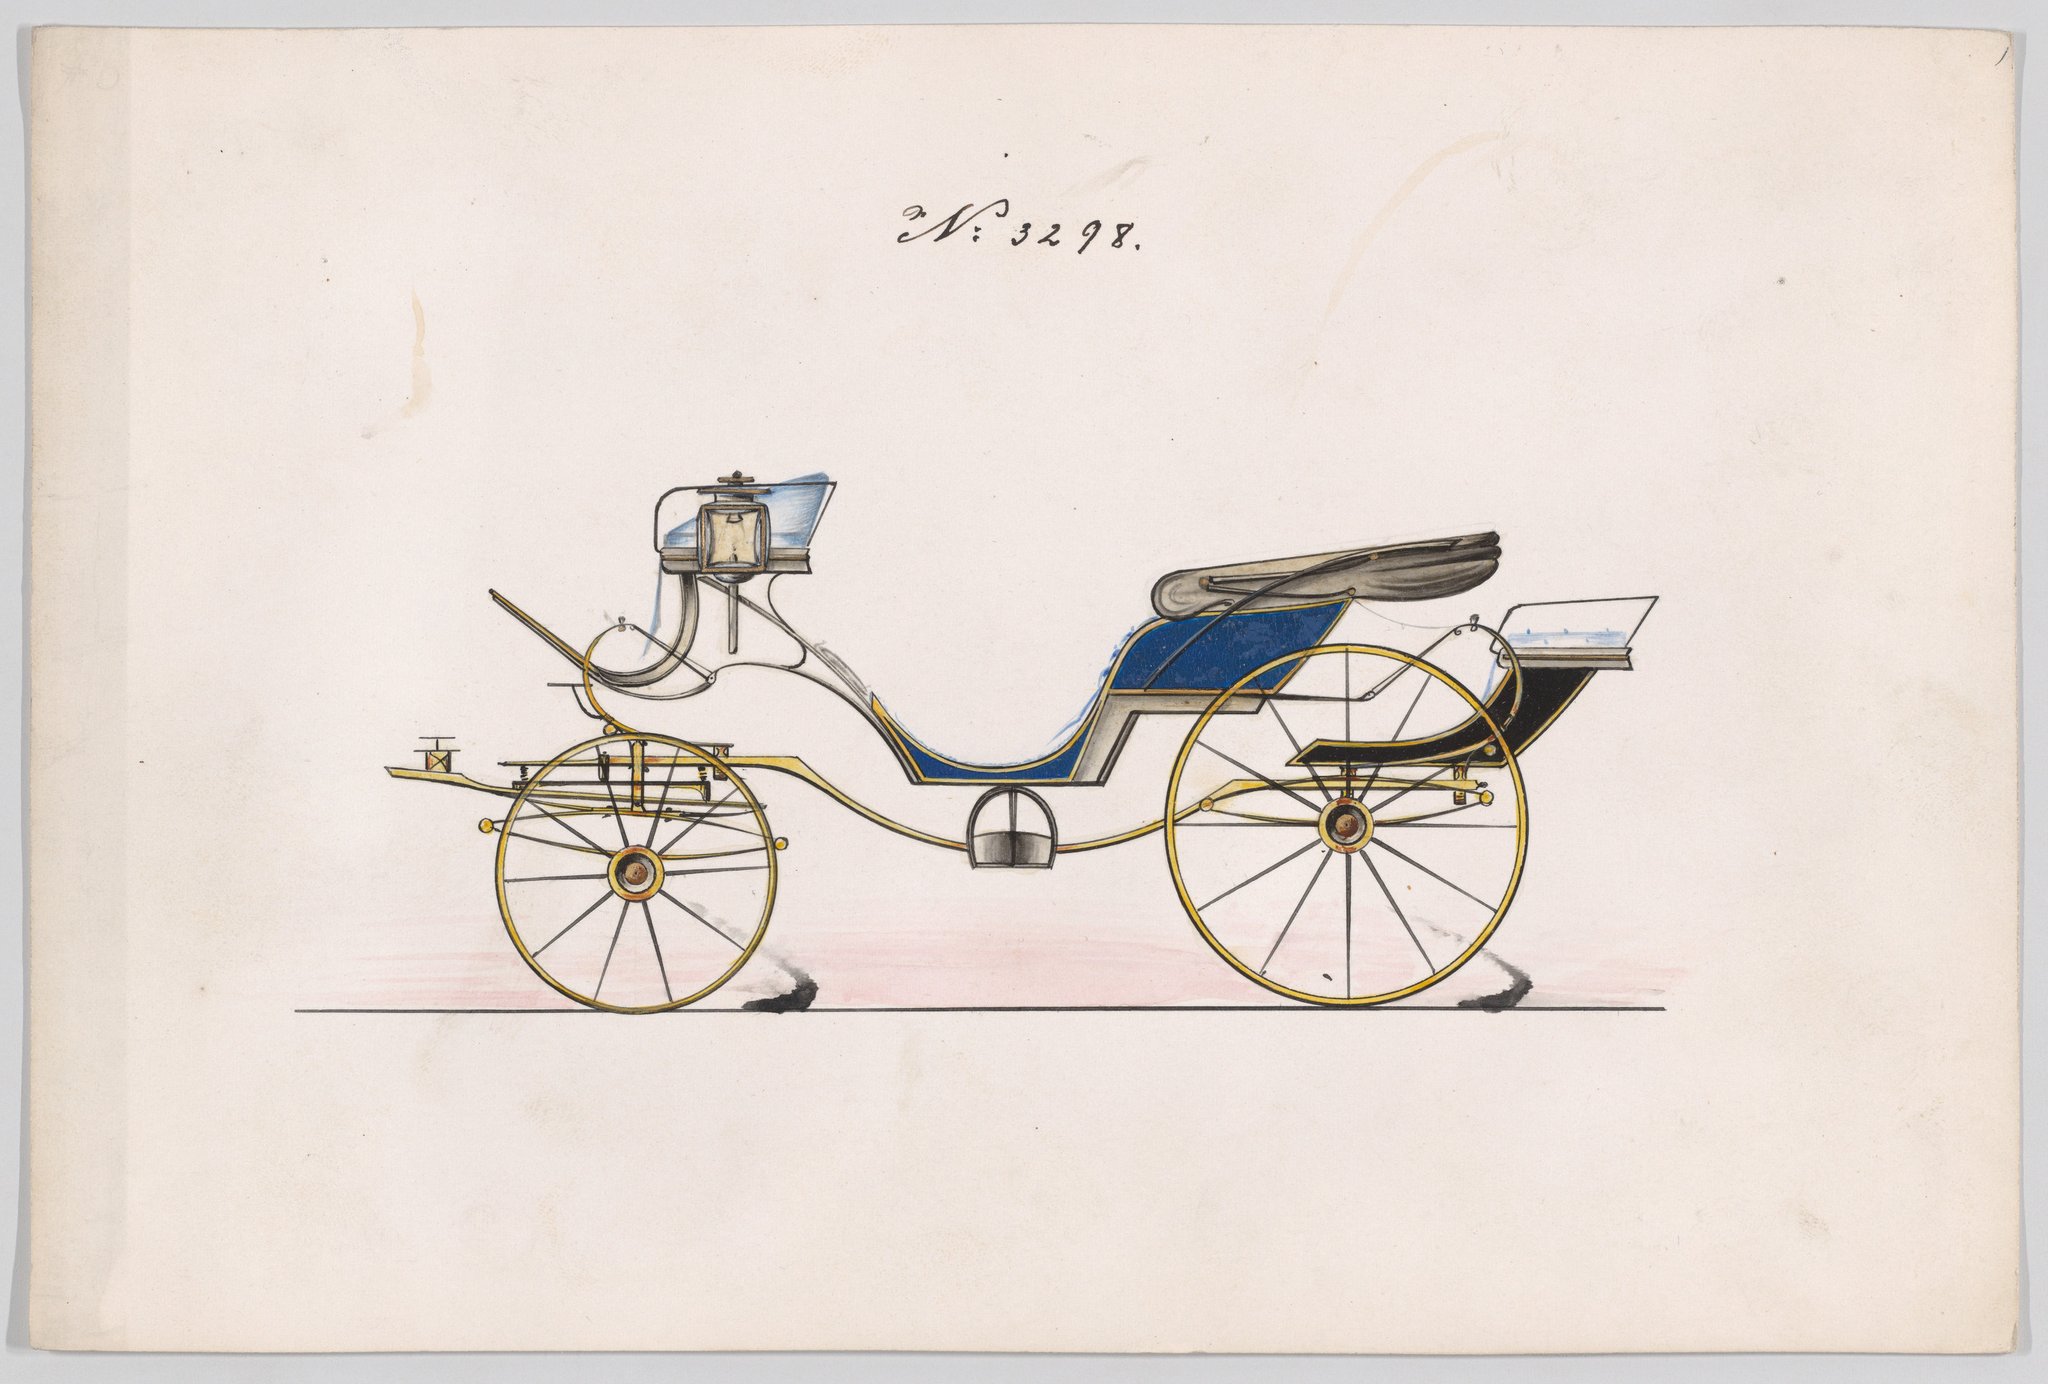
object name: drawing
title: Victoria #3298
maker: brewster & co.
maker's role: manufacturer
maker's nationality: american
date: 1877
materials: gouache, gum arabic, ink, watercolor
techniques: pen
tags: carriages